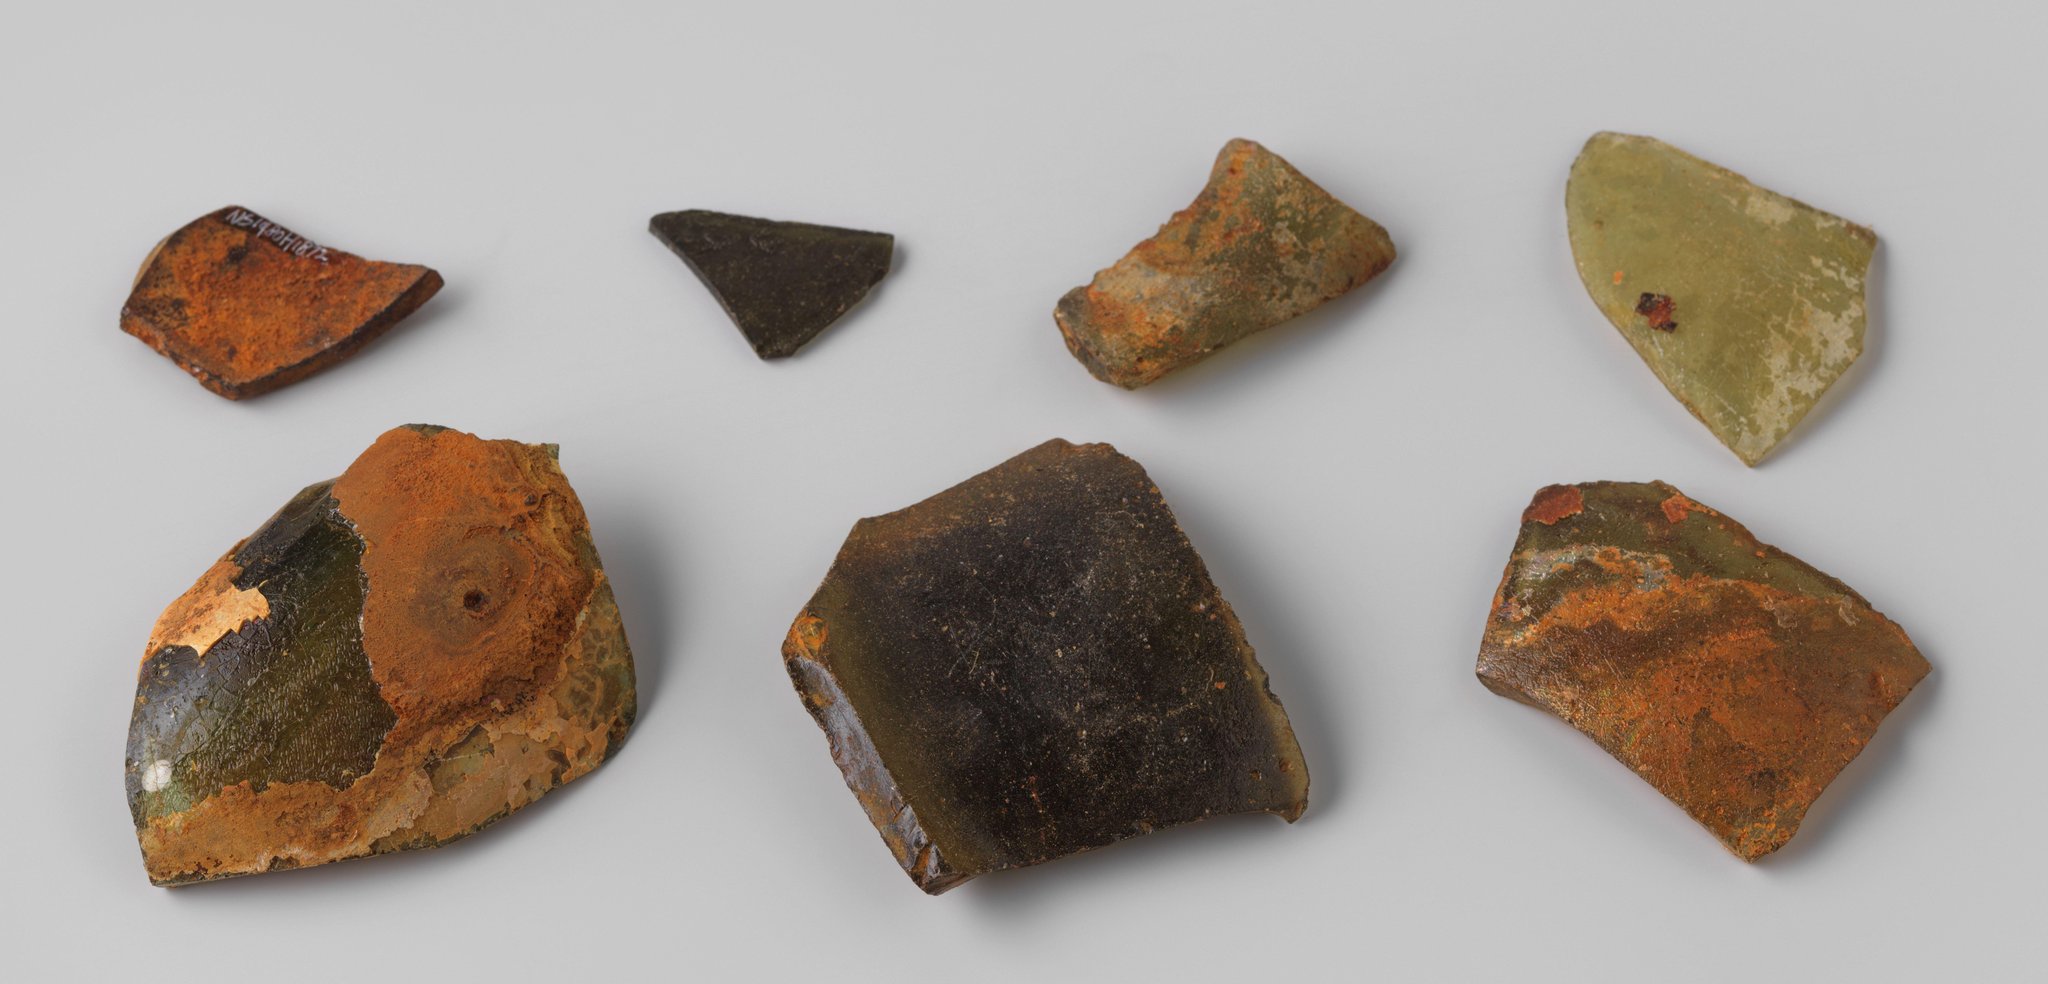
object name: wine bottle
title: Scherven van wijnflessen uit het wrak van de Oost-Indiëvaarder Hollandia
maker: Anonymous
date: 1700-1743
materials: glass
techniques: green glass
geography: netherlands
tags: verenigde oostindische compagnie, hollandia (schip), annet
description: Typologically not identifiable, belly, fragment.